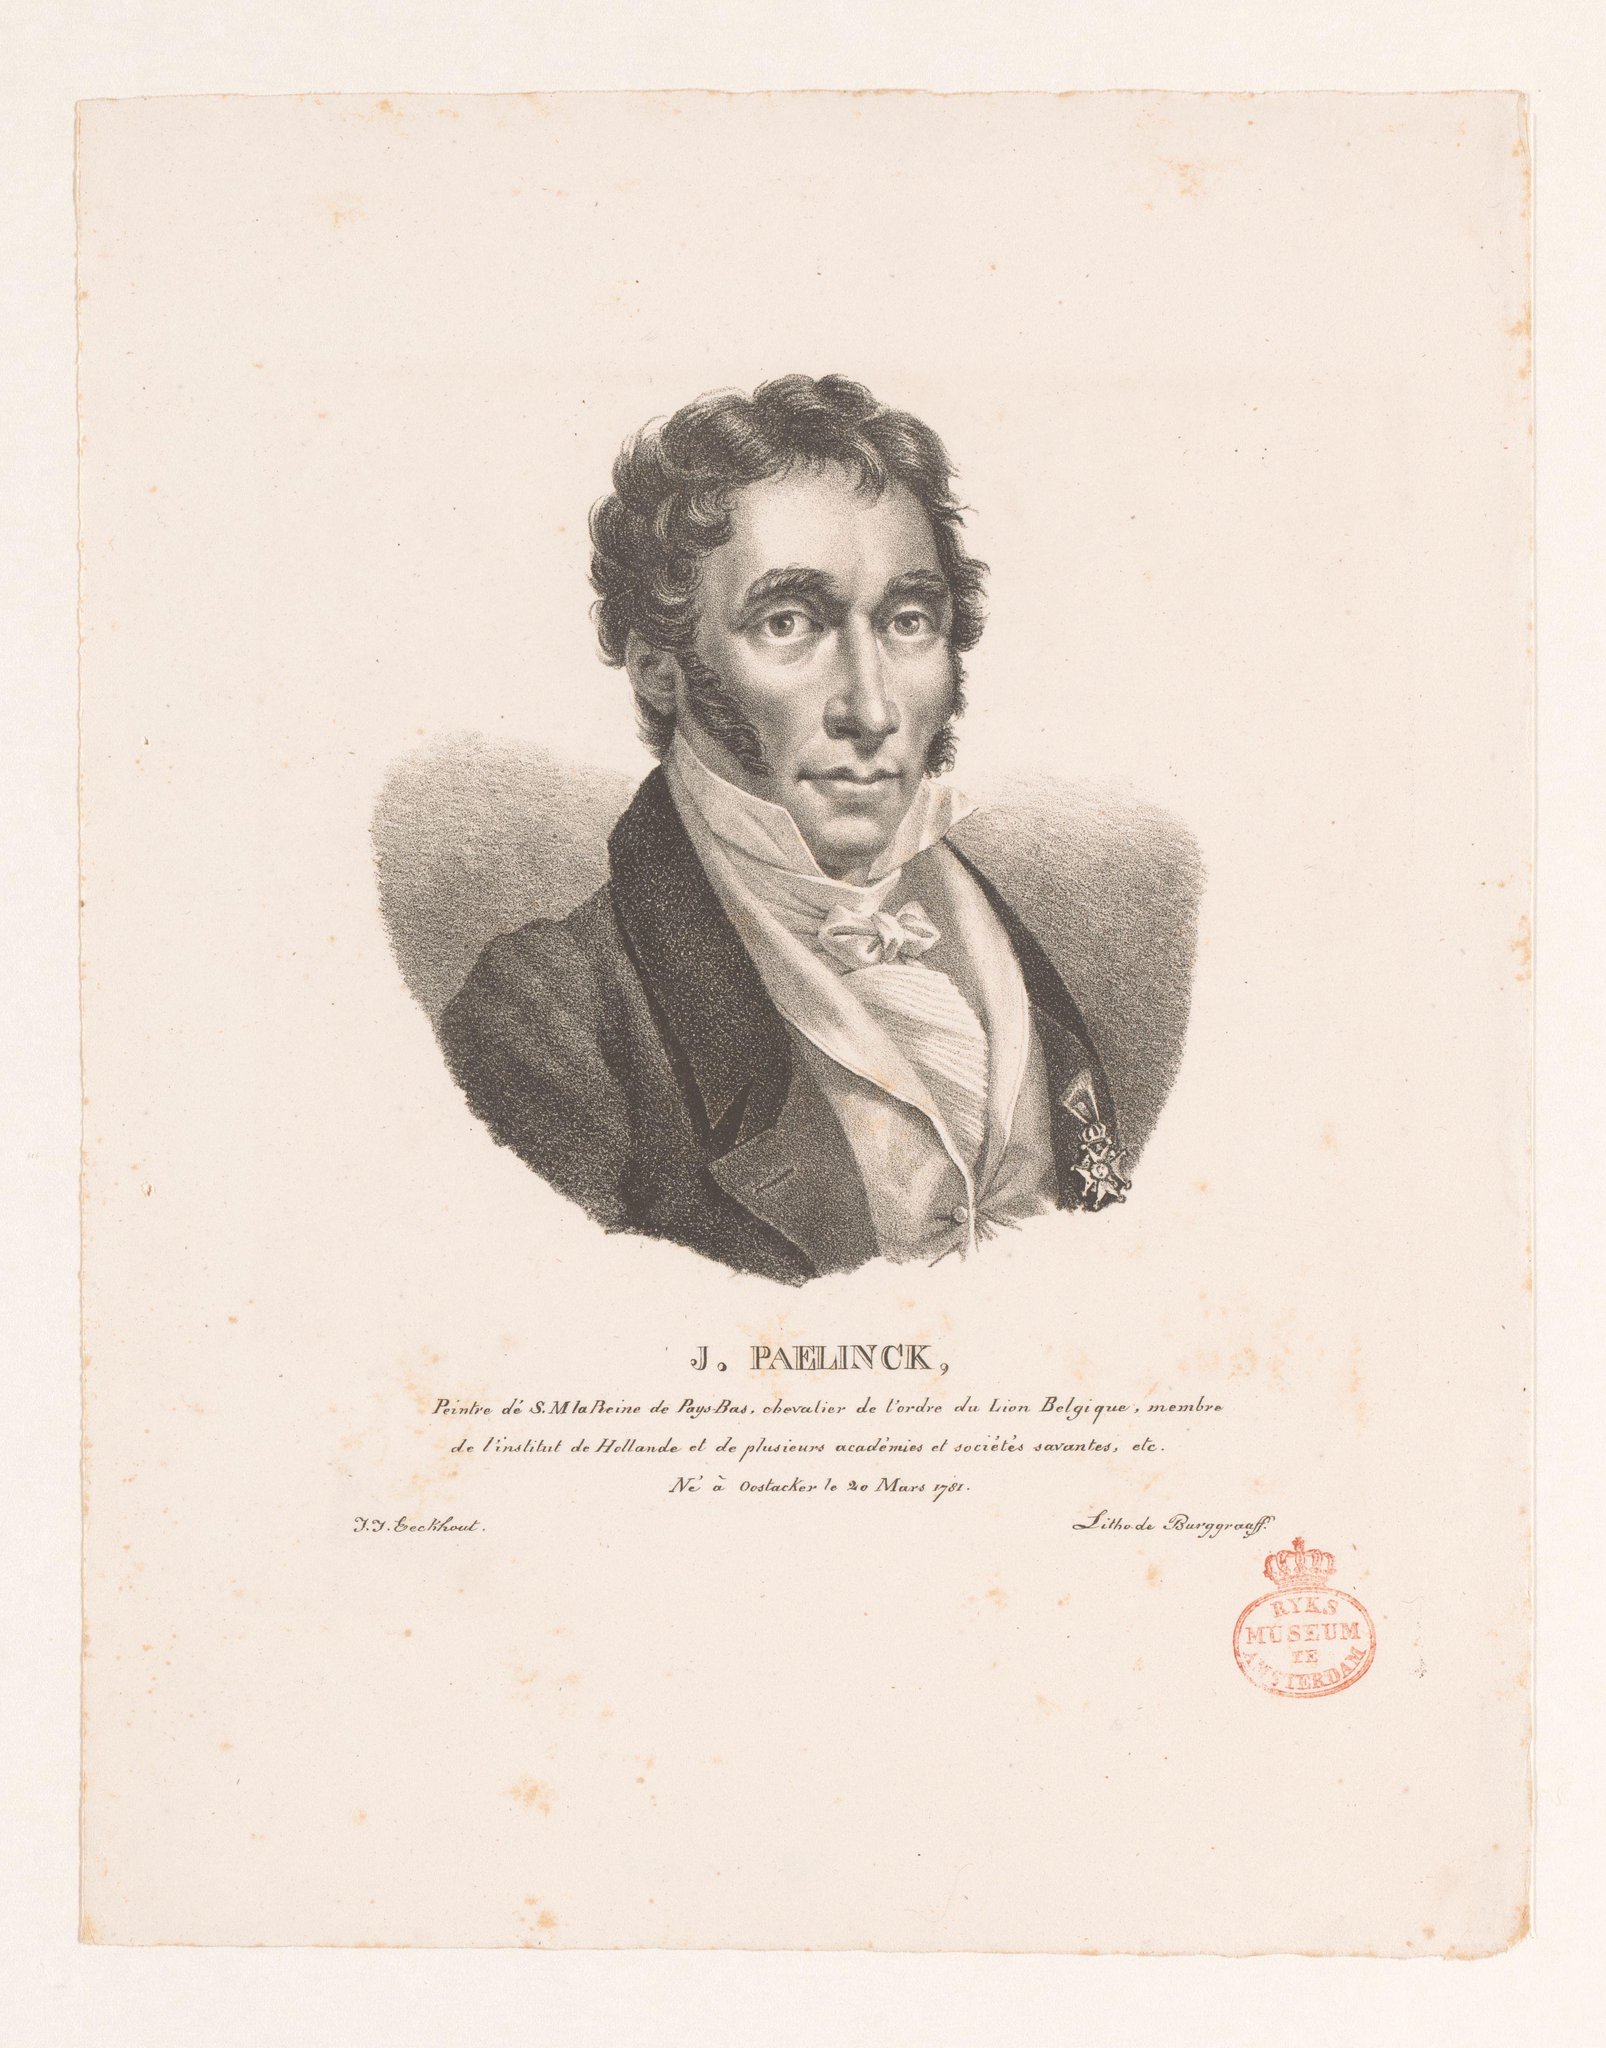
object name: print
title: Portretten van hedendaagse kunstenaars uit het Verenigd Koninkrijk der Nederlanden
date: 1822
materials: paper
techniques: lithograph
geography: brussels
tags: brussels, painter, joseph paelinck, historical persons, portrait, self-portrait of painter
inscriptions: collector's mark: Lugt 12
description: Prent maakt deel uit van een serie van zestig prenten.